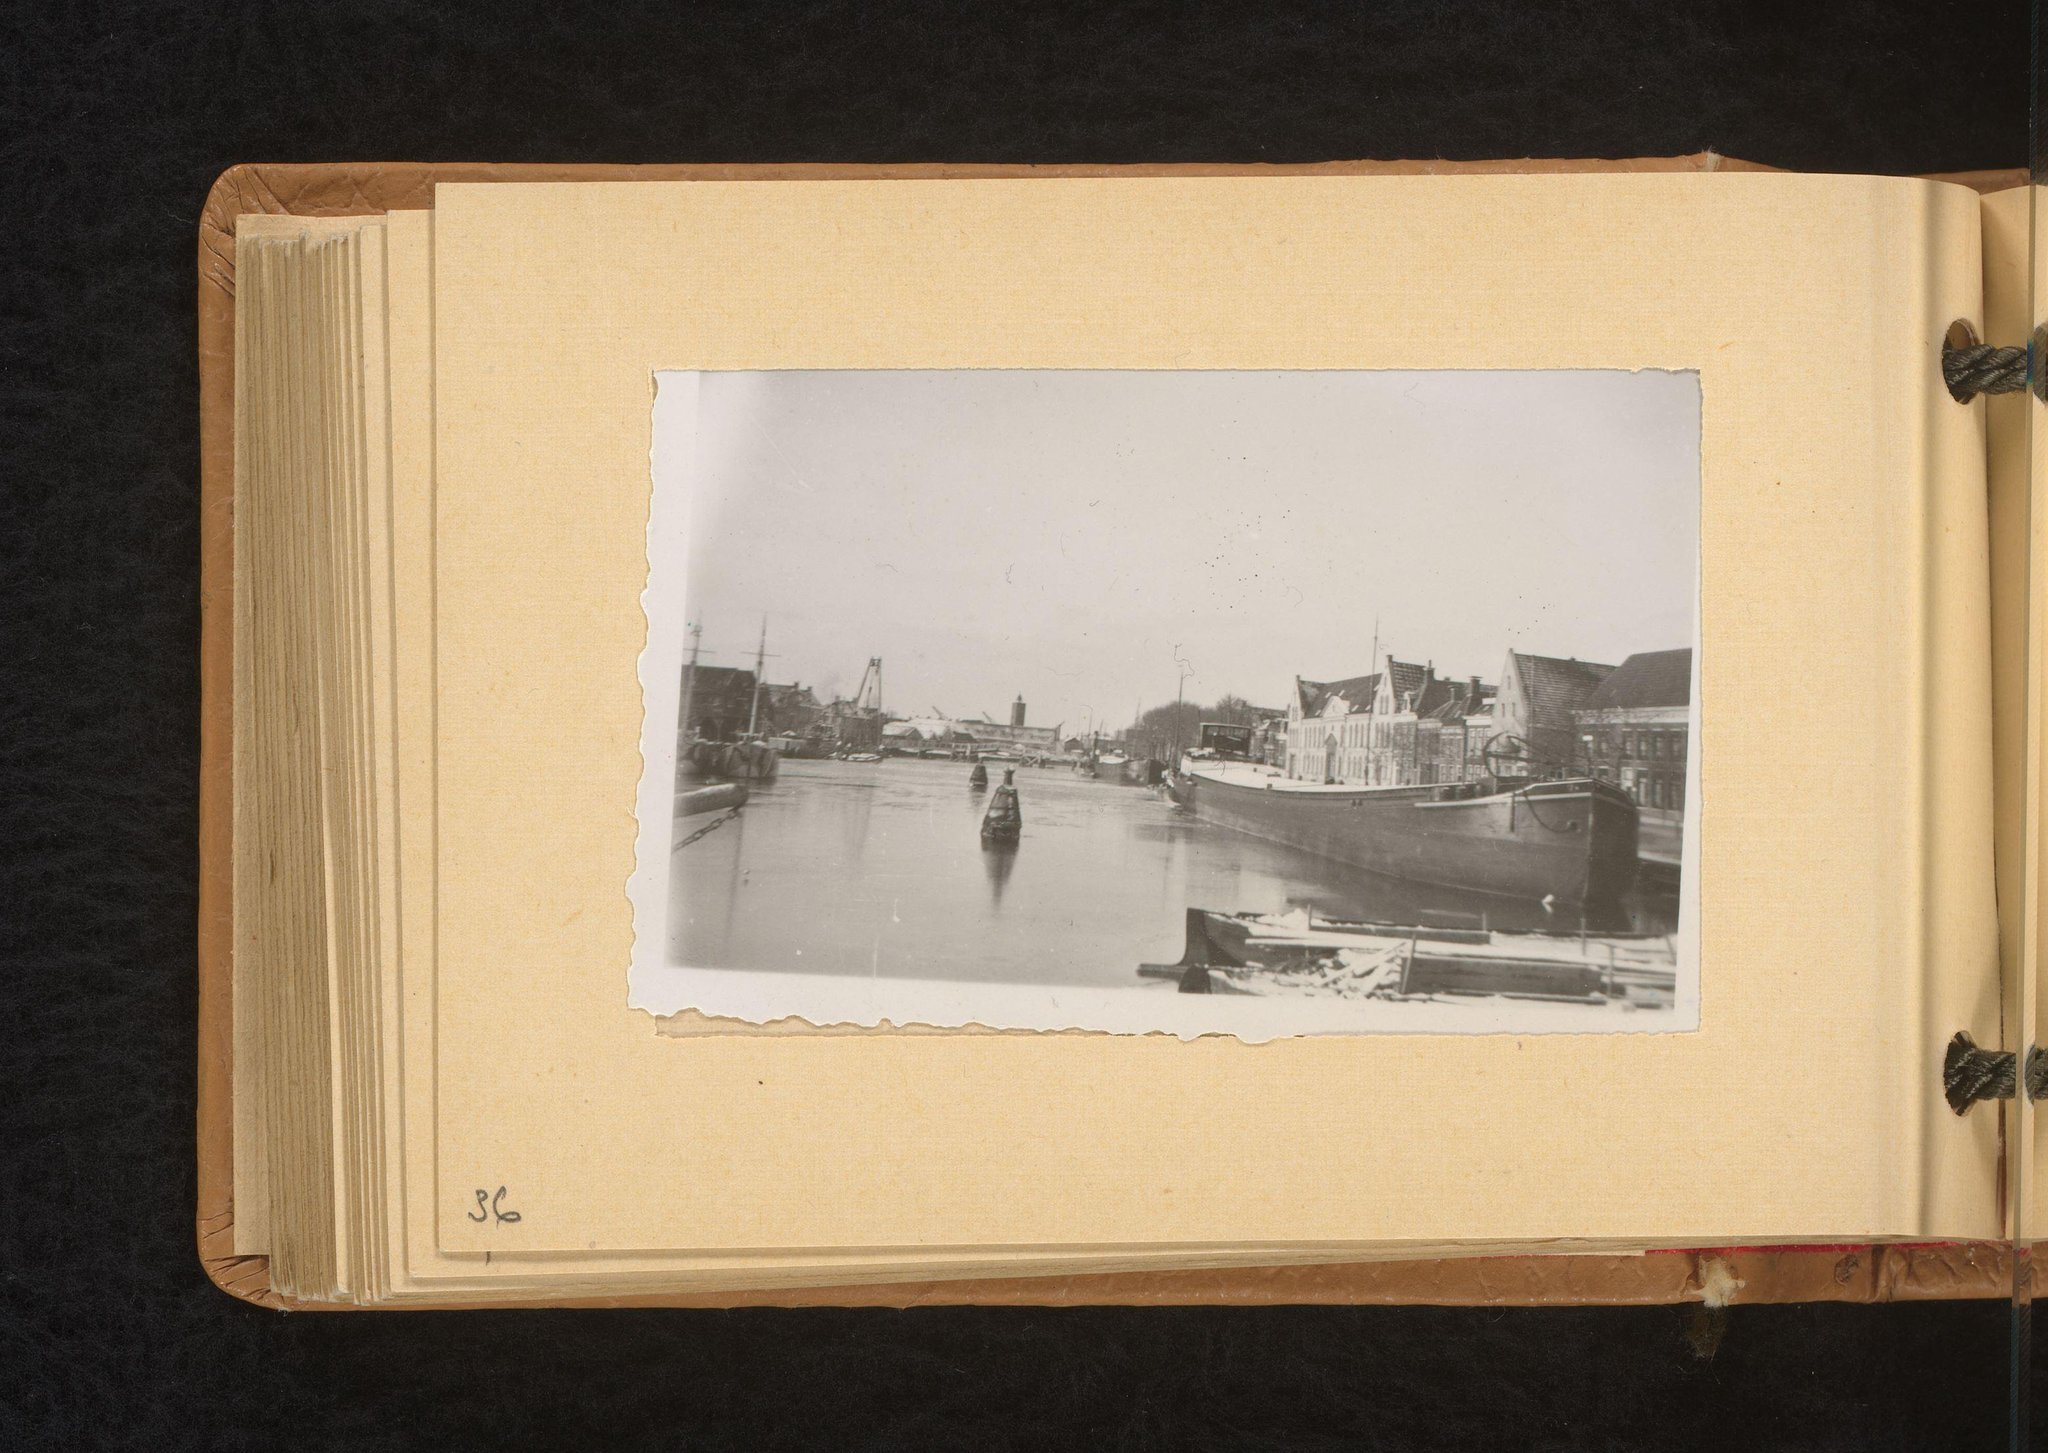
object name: photograph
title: Haven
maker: Anonymous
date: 1940-1943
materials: paper, photographic support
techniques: gelatin silver print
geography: netherlands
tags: harbour, occupation ~ war, netherlands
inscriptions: name: ‘-Drogerie / A 333 / ... mm’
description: Albumblad met een foto van een haven met afgemeerde binnenvaartschepen. Onderdeel van een klein album van de Kriegsmarine in Nederland.